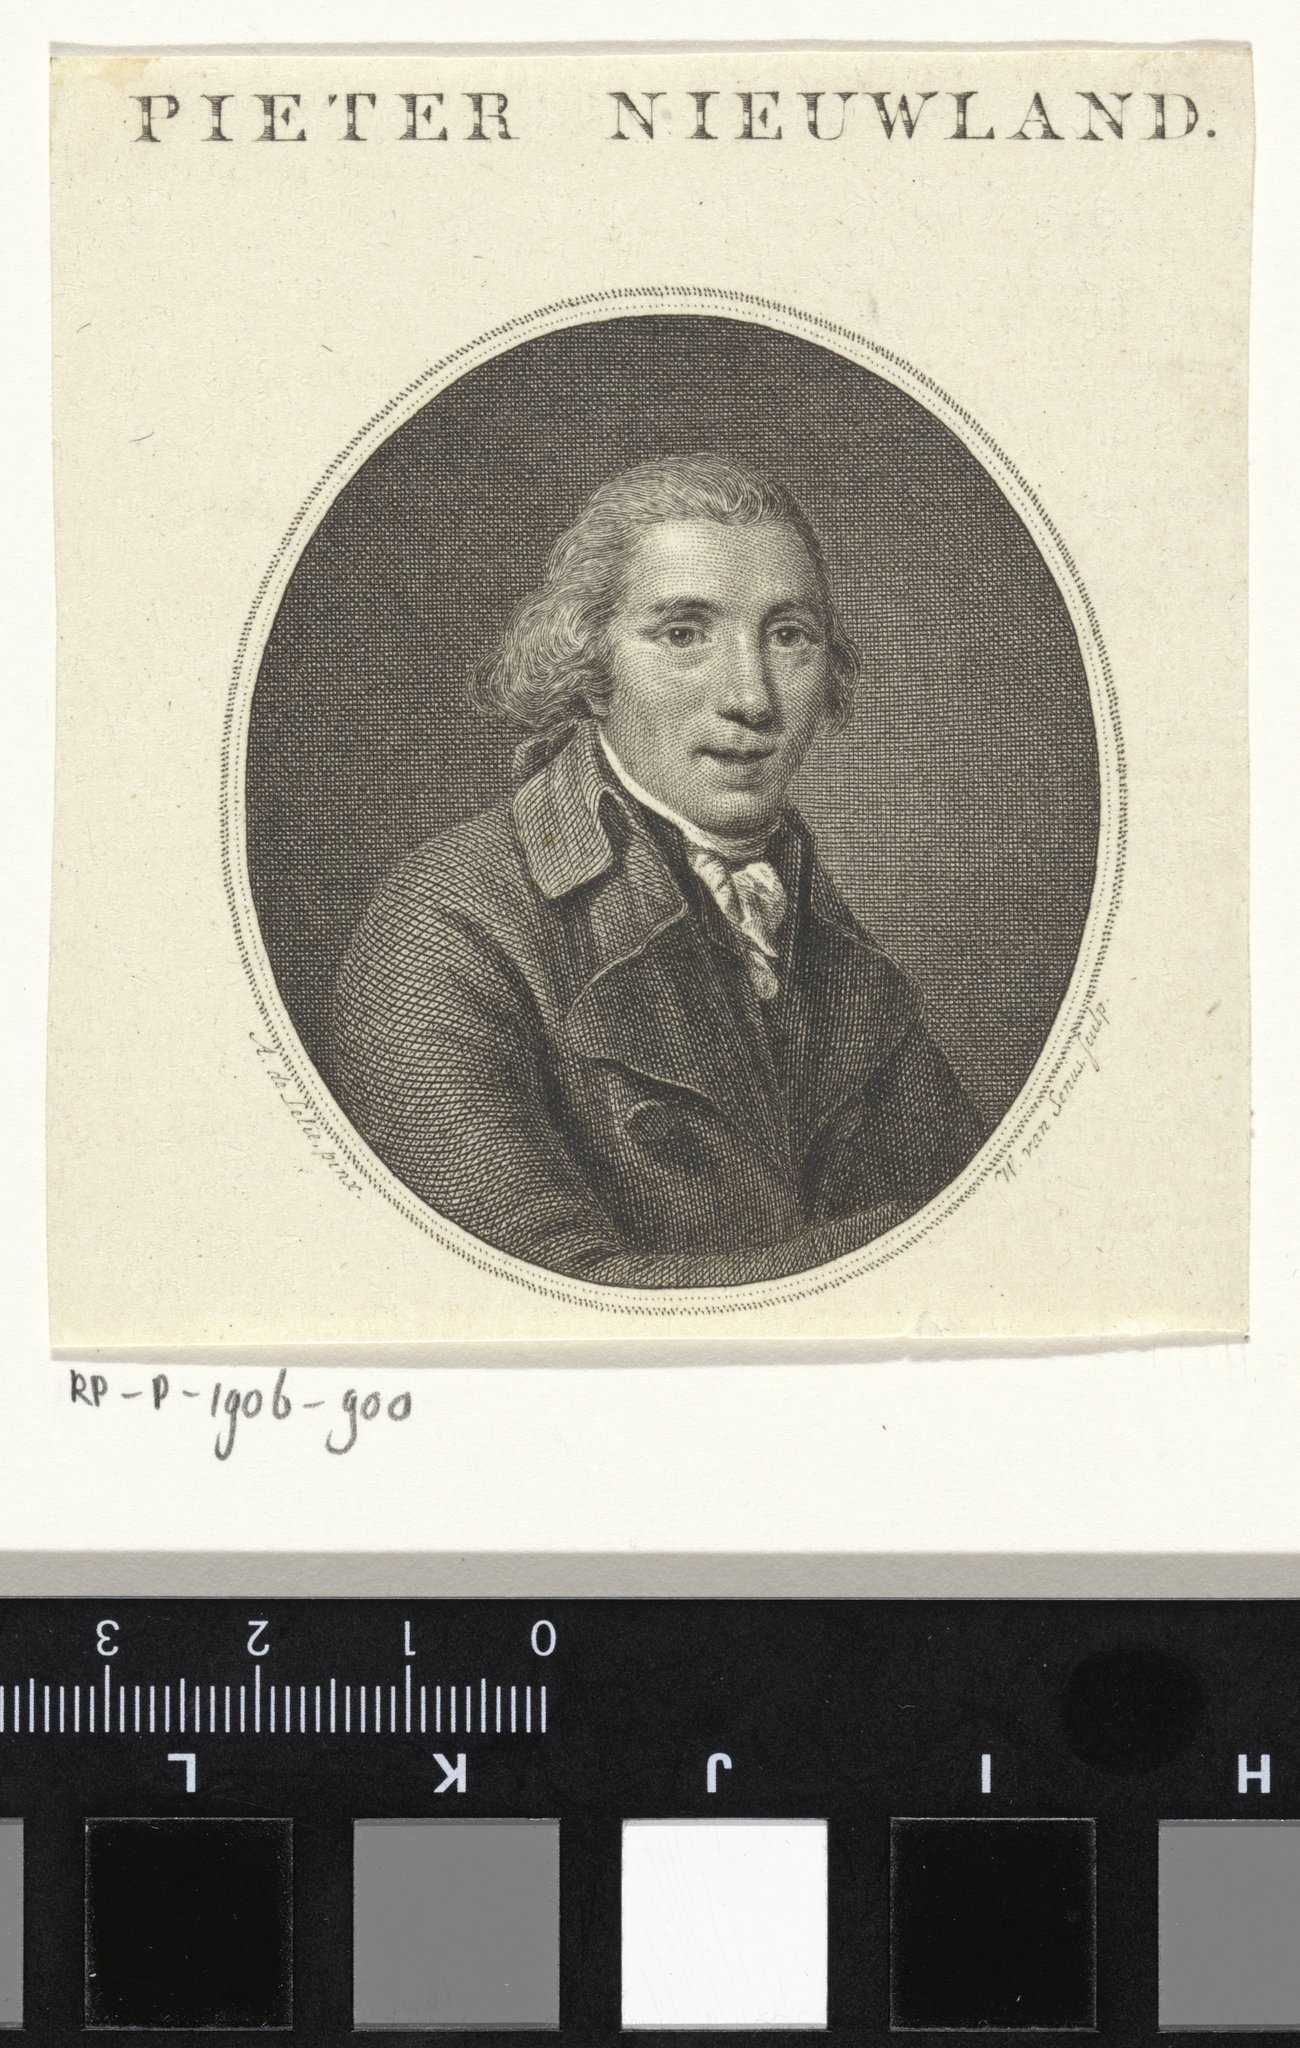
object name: print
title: Portret van de dichter Pieter Nieuwland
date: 1824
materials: paper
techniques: engraving, etching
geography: netherlands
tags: watergraafsmeer, hoogleraar, pieter nieuwland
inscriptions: collector's mark: Lugt 2228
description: Prent gebruikt op titelpagina van: Nieuwland, Piieter. Gedichten en redevoeringen. Amsterdam: Ten Brink en De Vries, 1824.